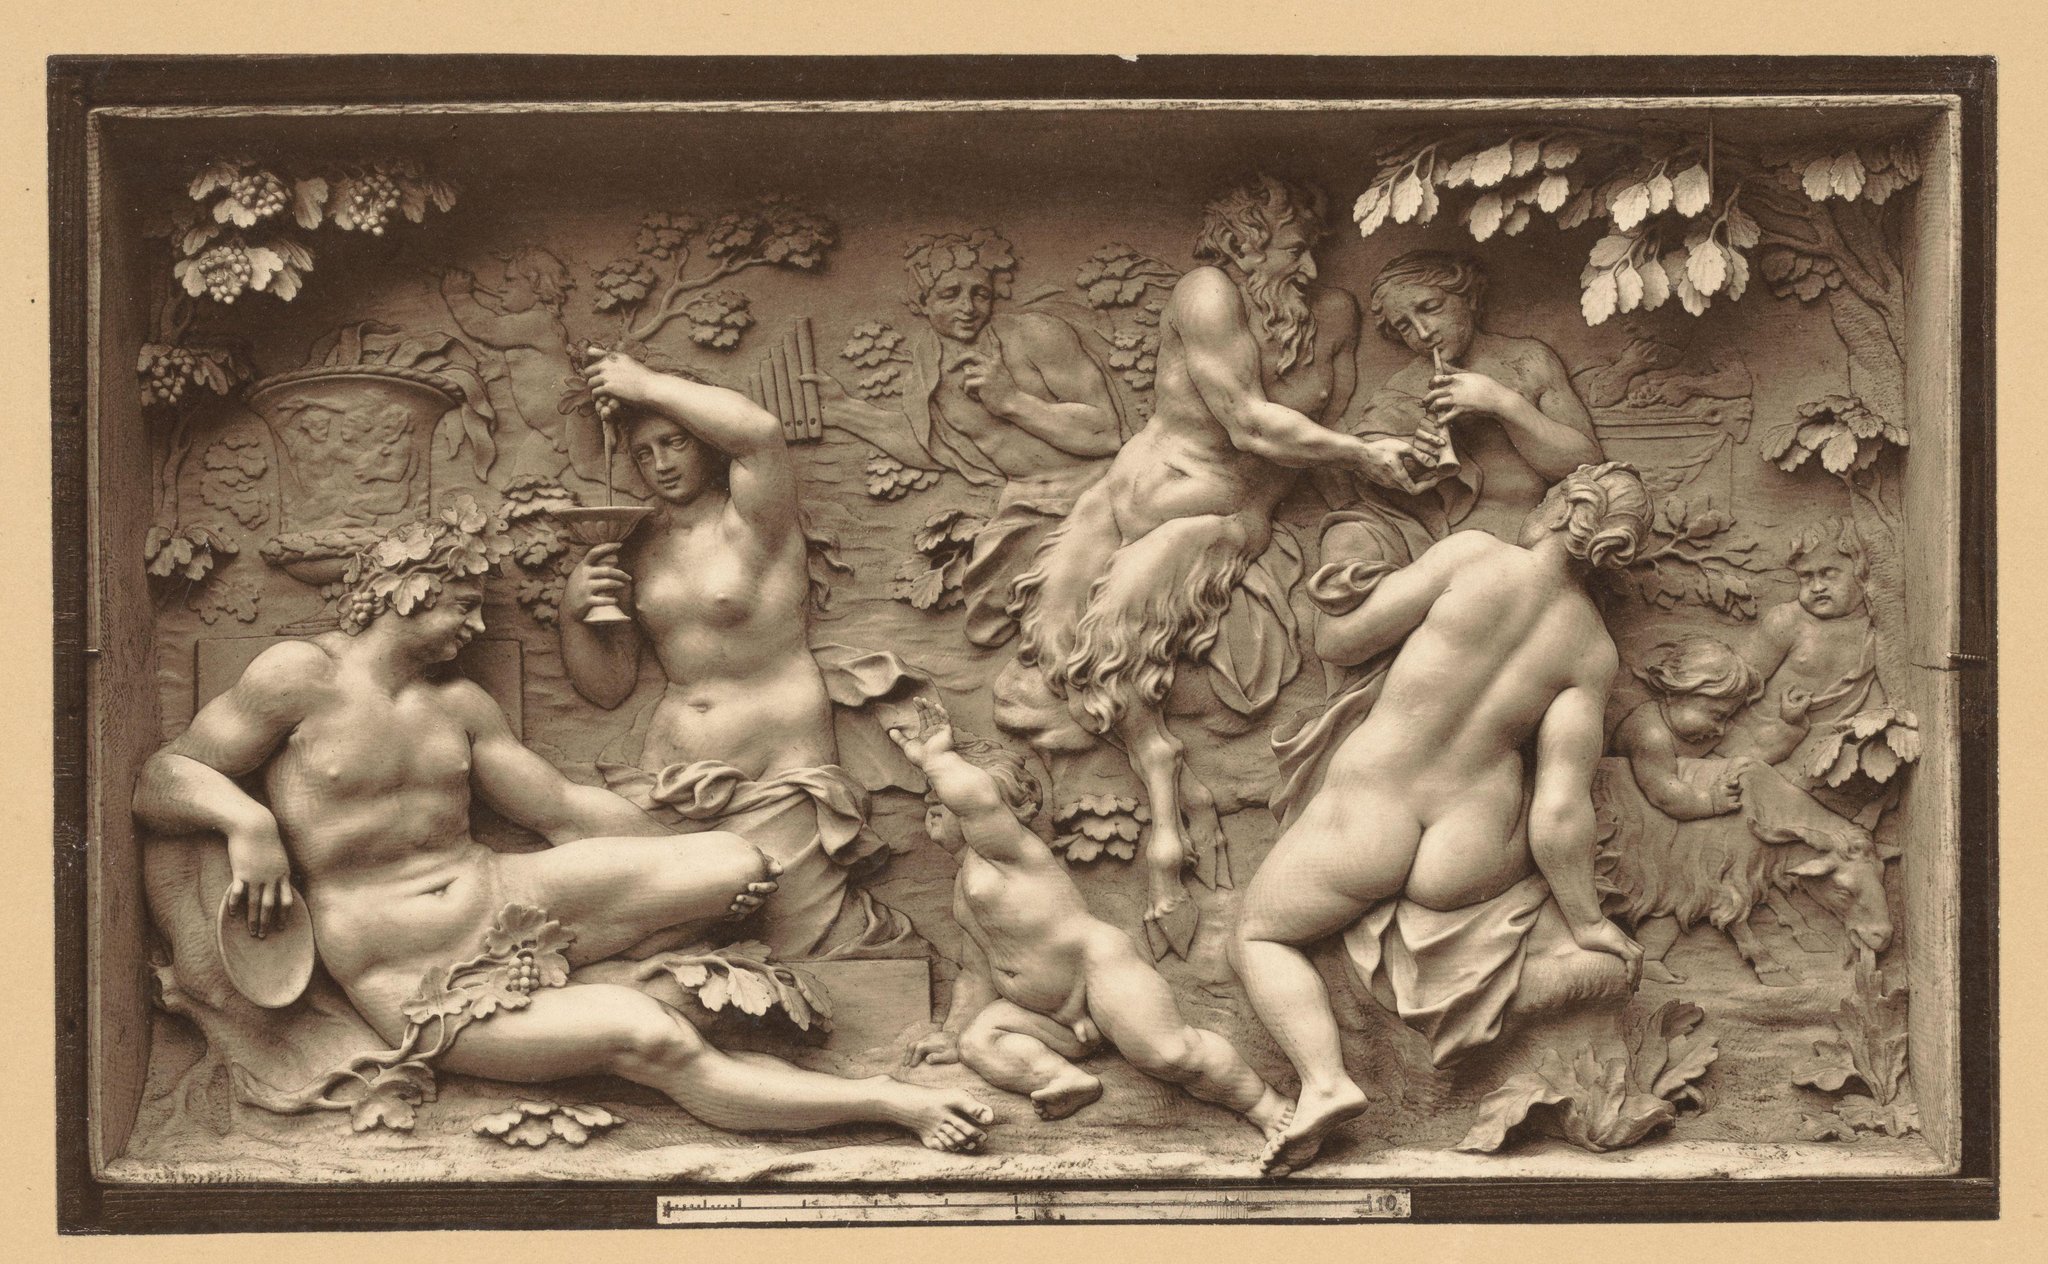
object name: photomechanical print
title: Hautrelief in Elfenbein von J. Elhafen. 1710. Bacchanale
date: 1869-1887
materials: cardboard, paper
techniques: photograph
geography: munich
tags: bacchanal: bacchus with his wine-flushed train (thiasos), piece of sculpture, reproduction of a piece of sculpture, germany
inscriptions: number: ‘Blatt 180.’